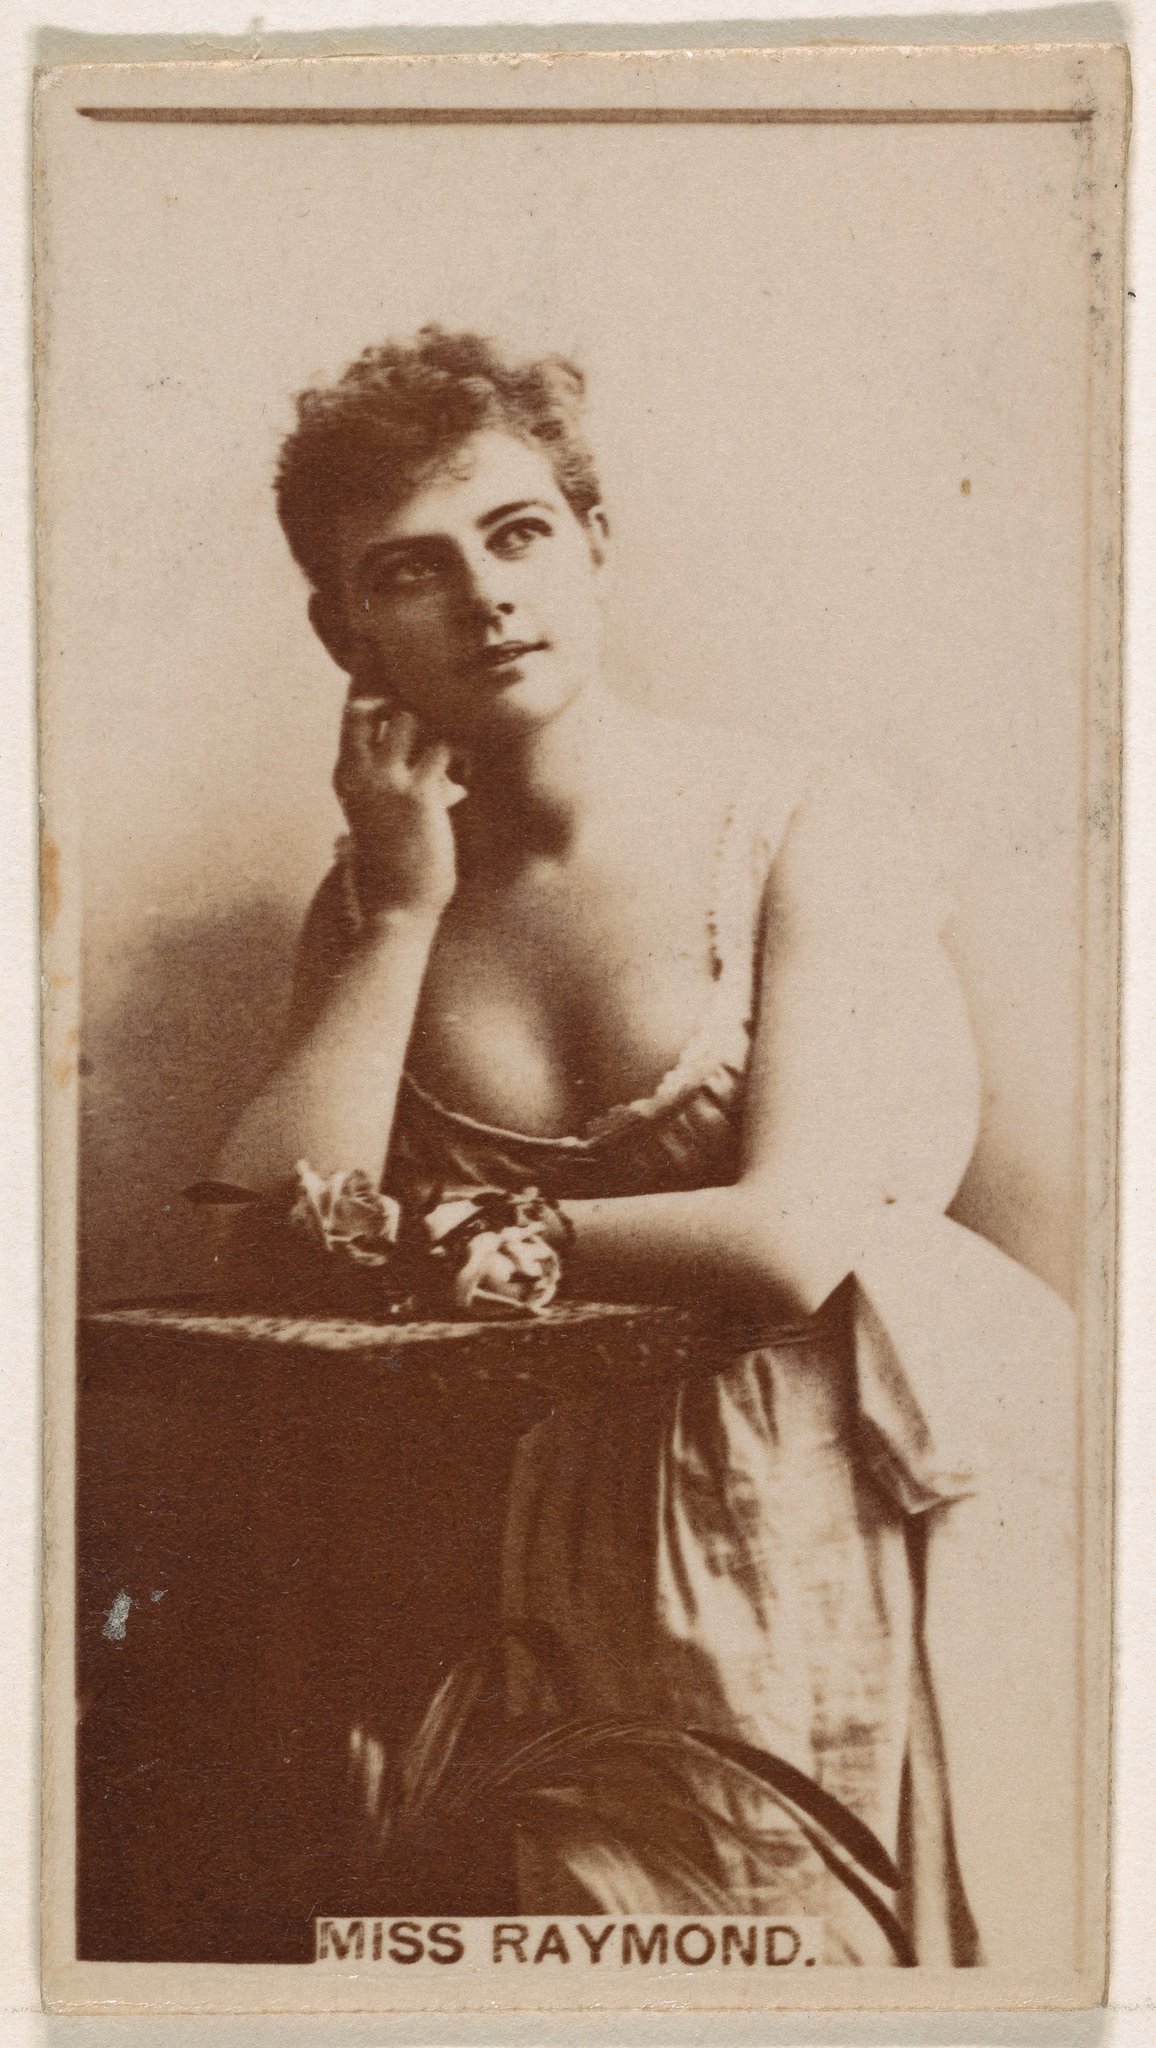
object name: photograph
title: Frankie Raymond, from the Actresses series (N245) issued by Kinney Brothers to promote Sweet Caporal Cigarettes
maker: kinney brothers tobacco company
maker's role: publisher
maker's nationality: american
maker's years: 1869-2011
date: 1890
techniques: albumen silver print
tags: portraits,women,actresses